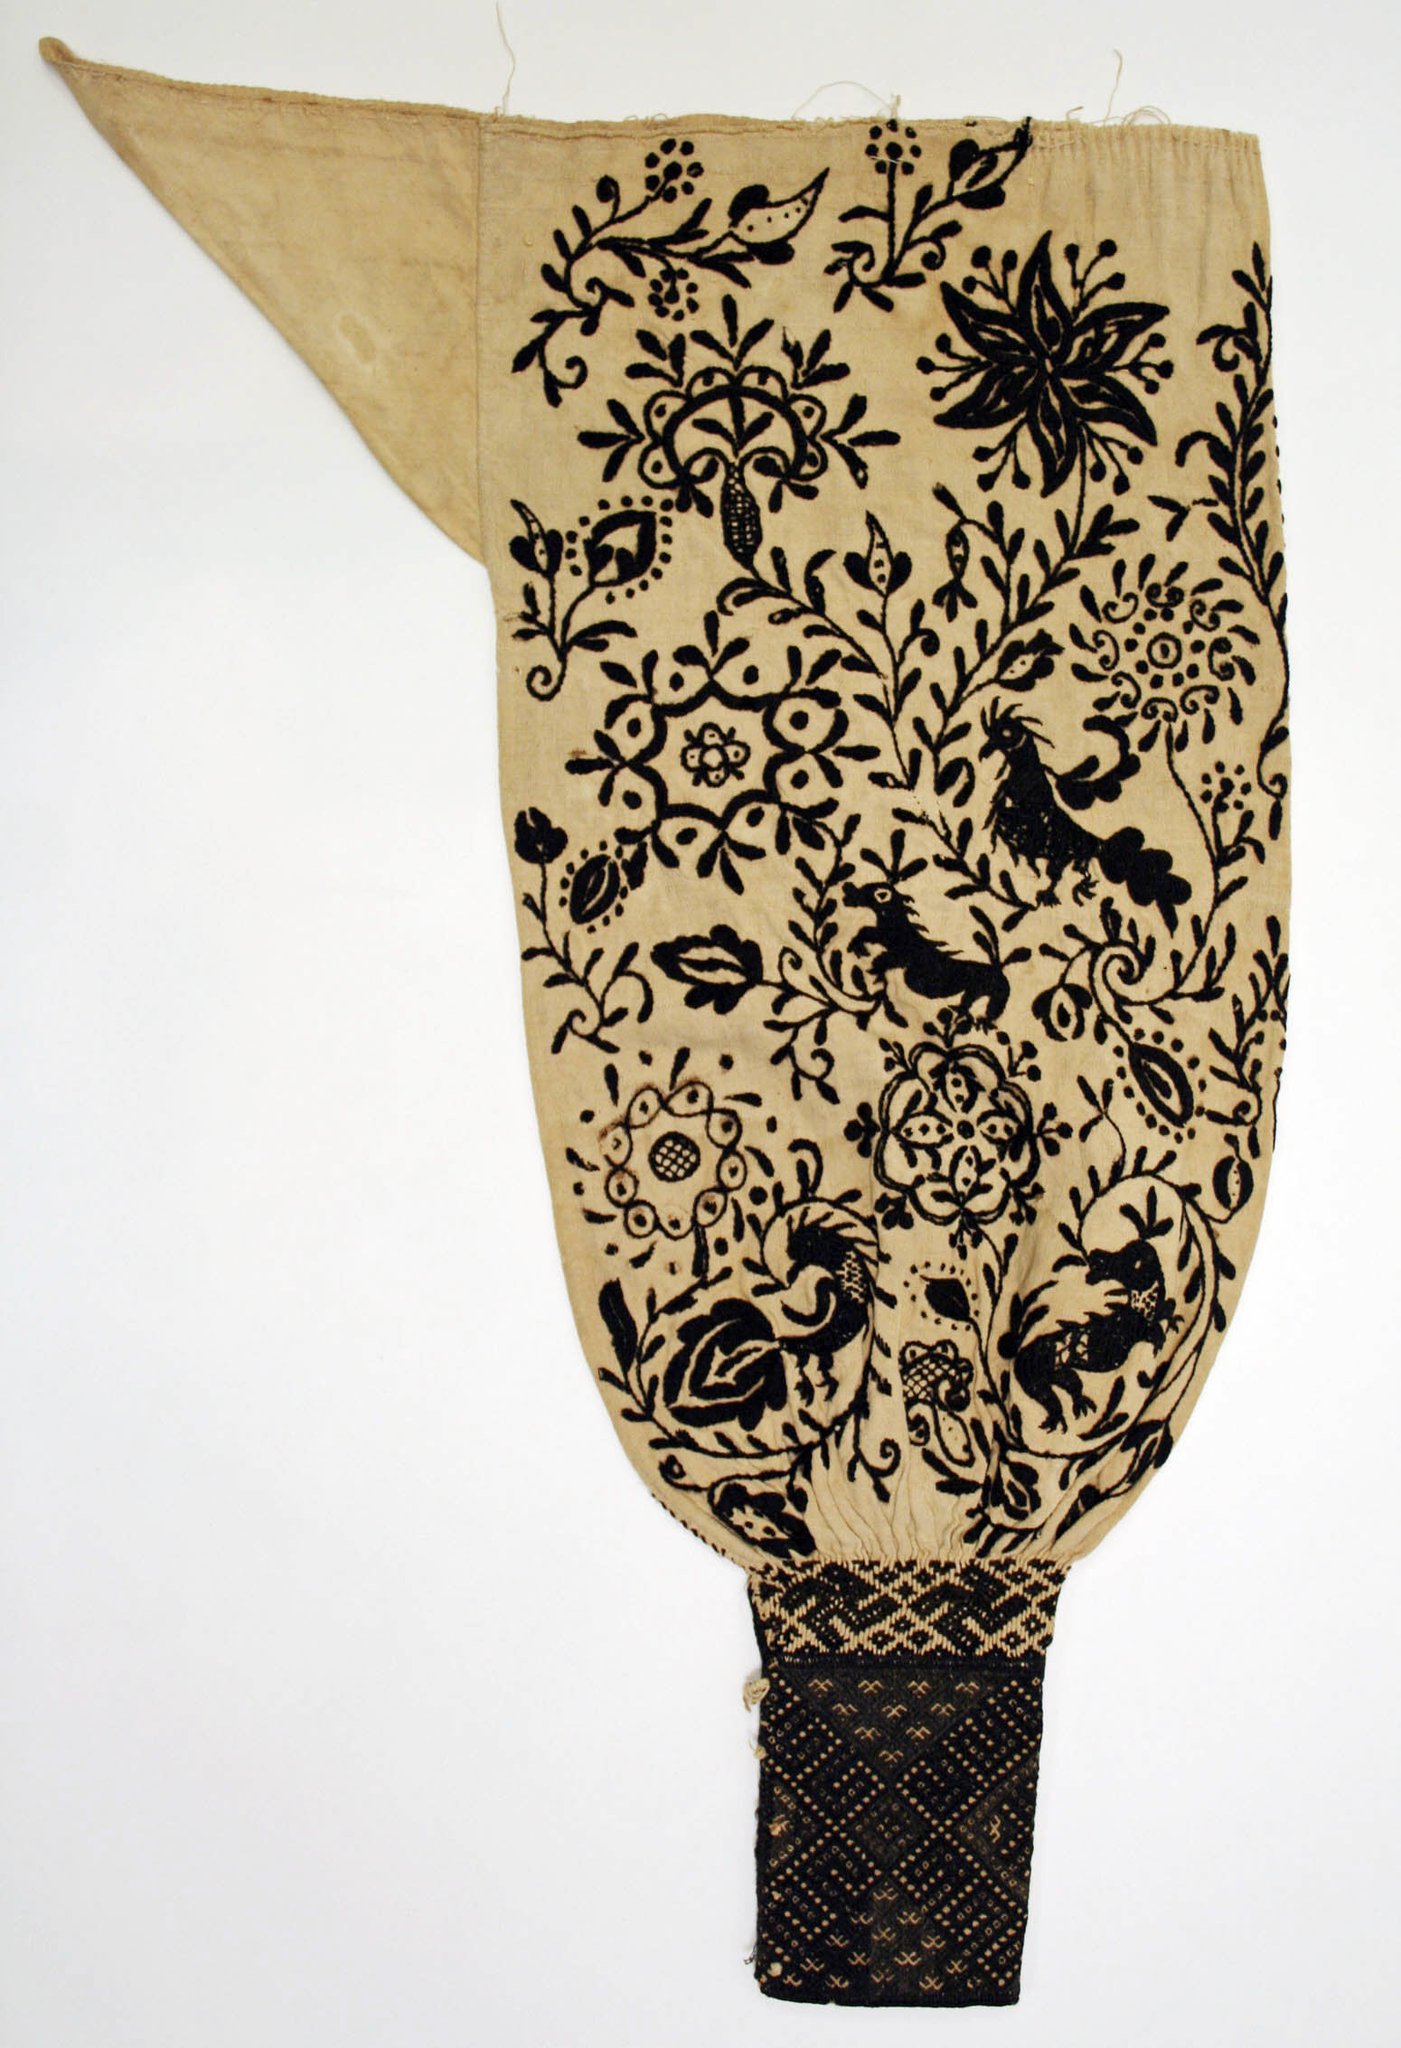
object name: sleeve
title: Sleeves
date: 1601-1800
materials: linen, wool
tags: birds